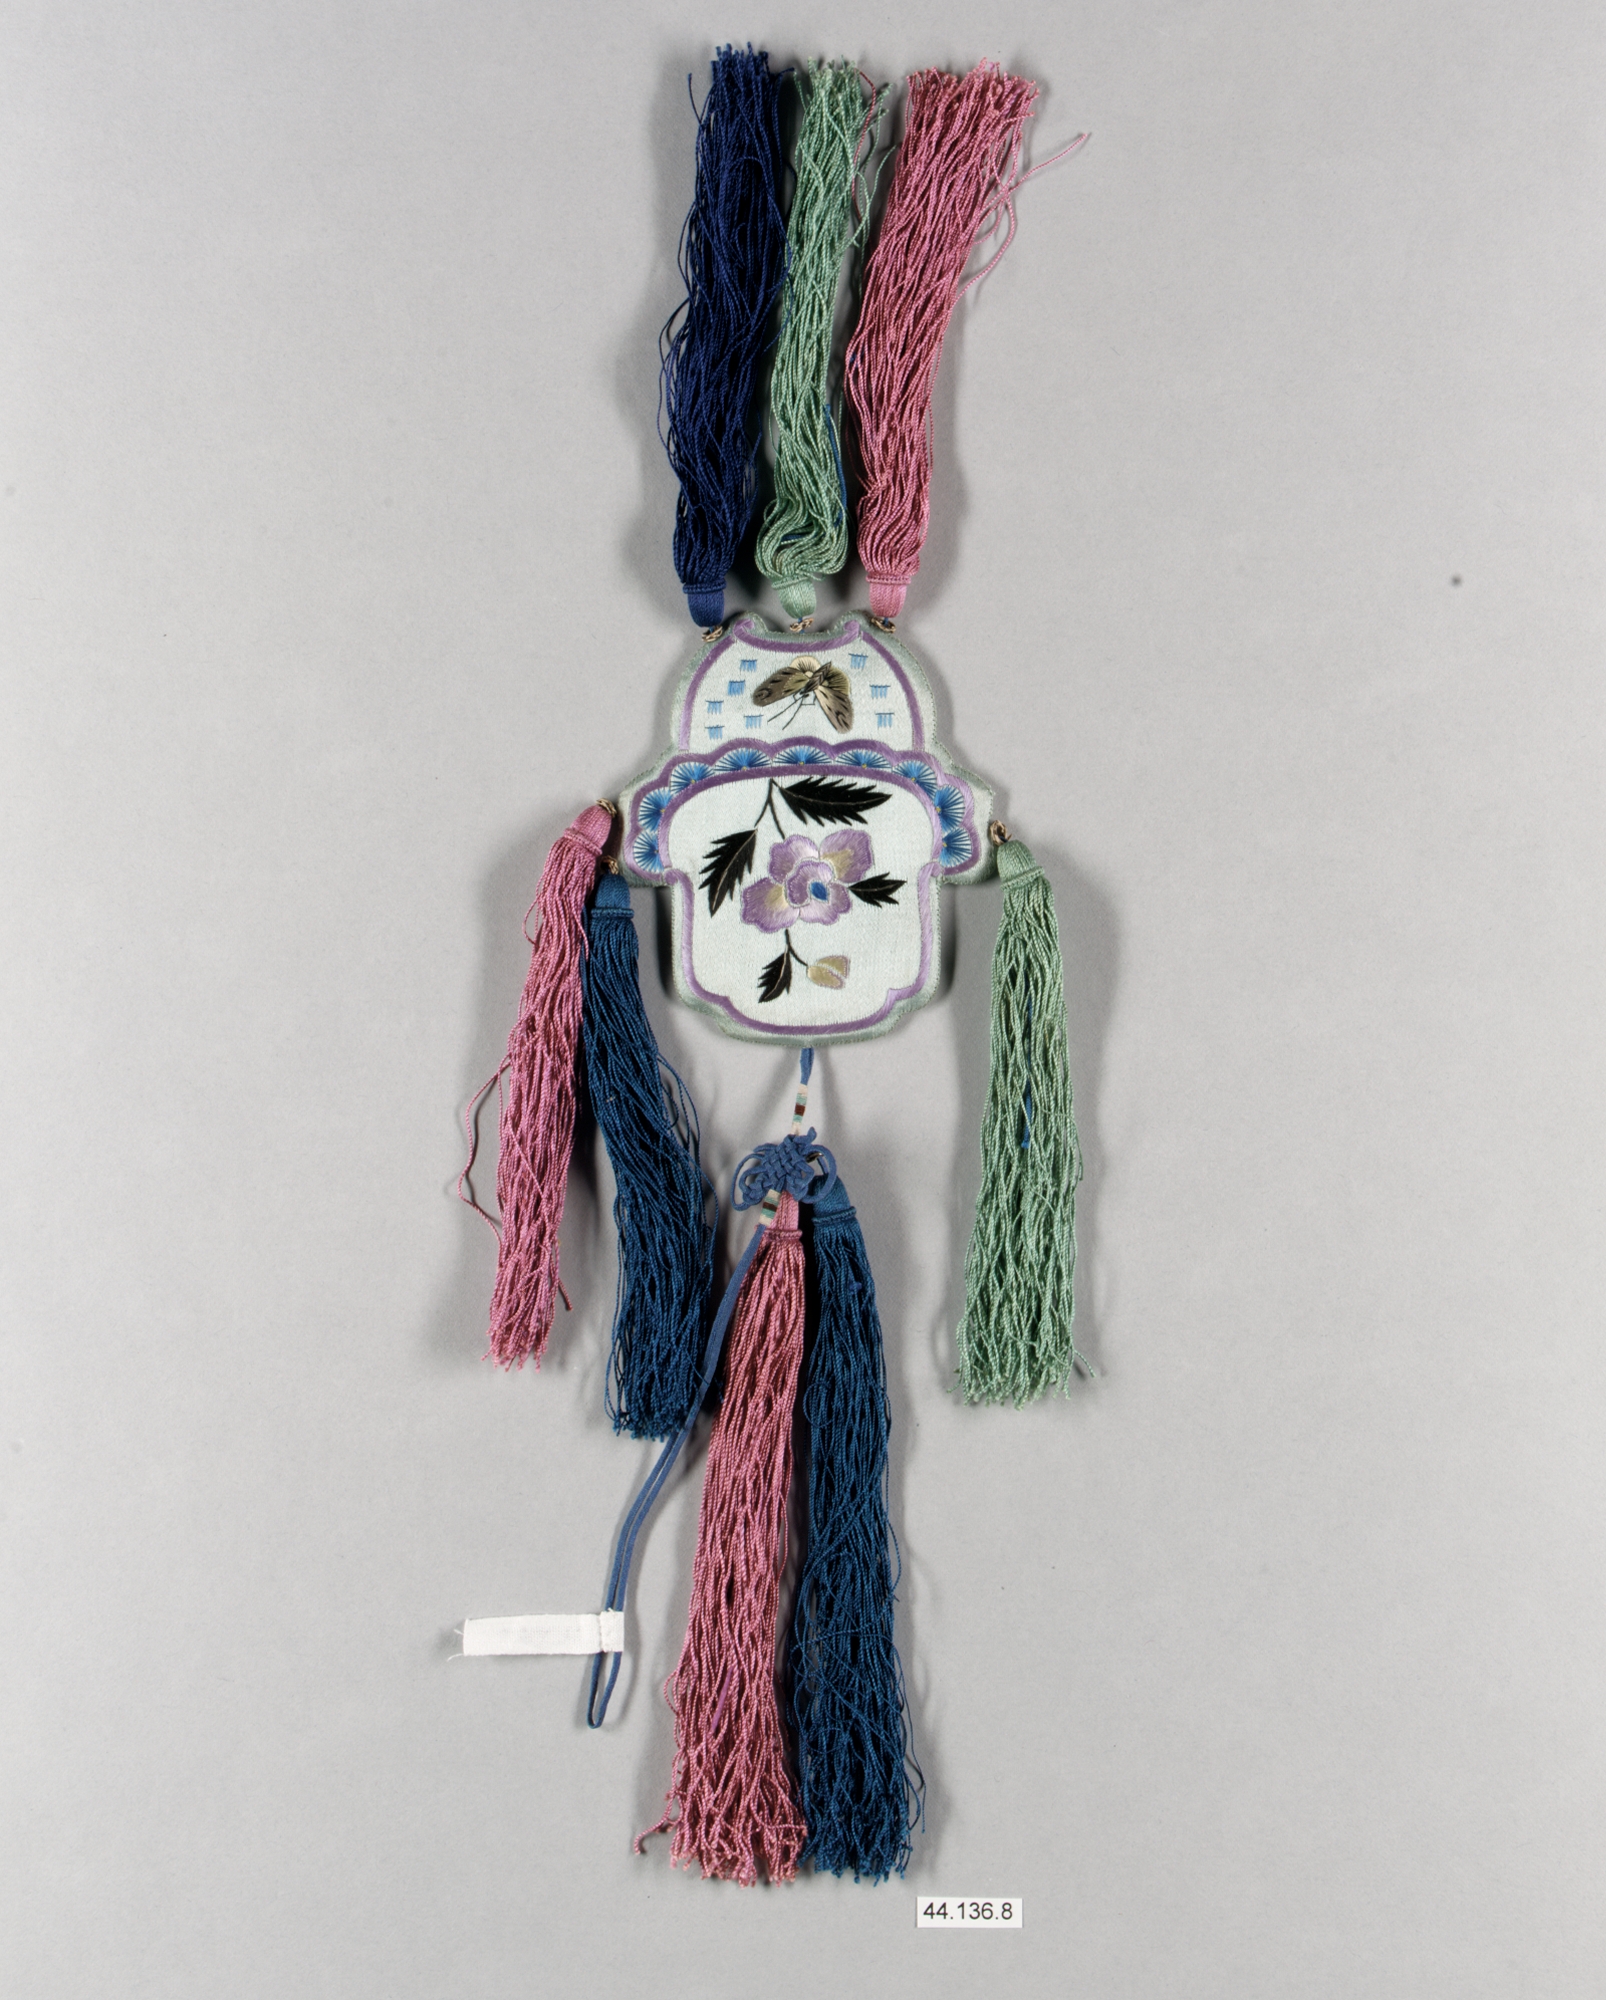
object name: mirror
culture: chinese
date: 1801-1900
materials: glass, silk